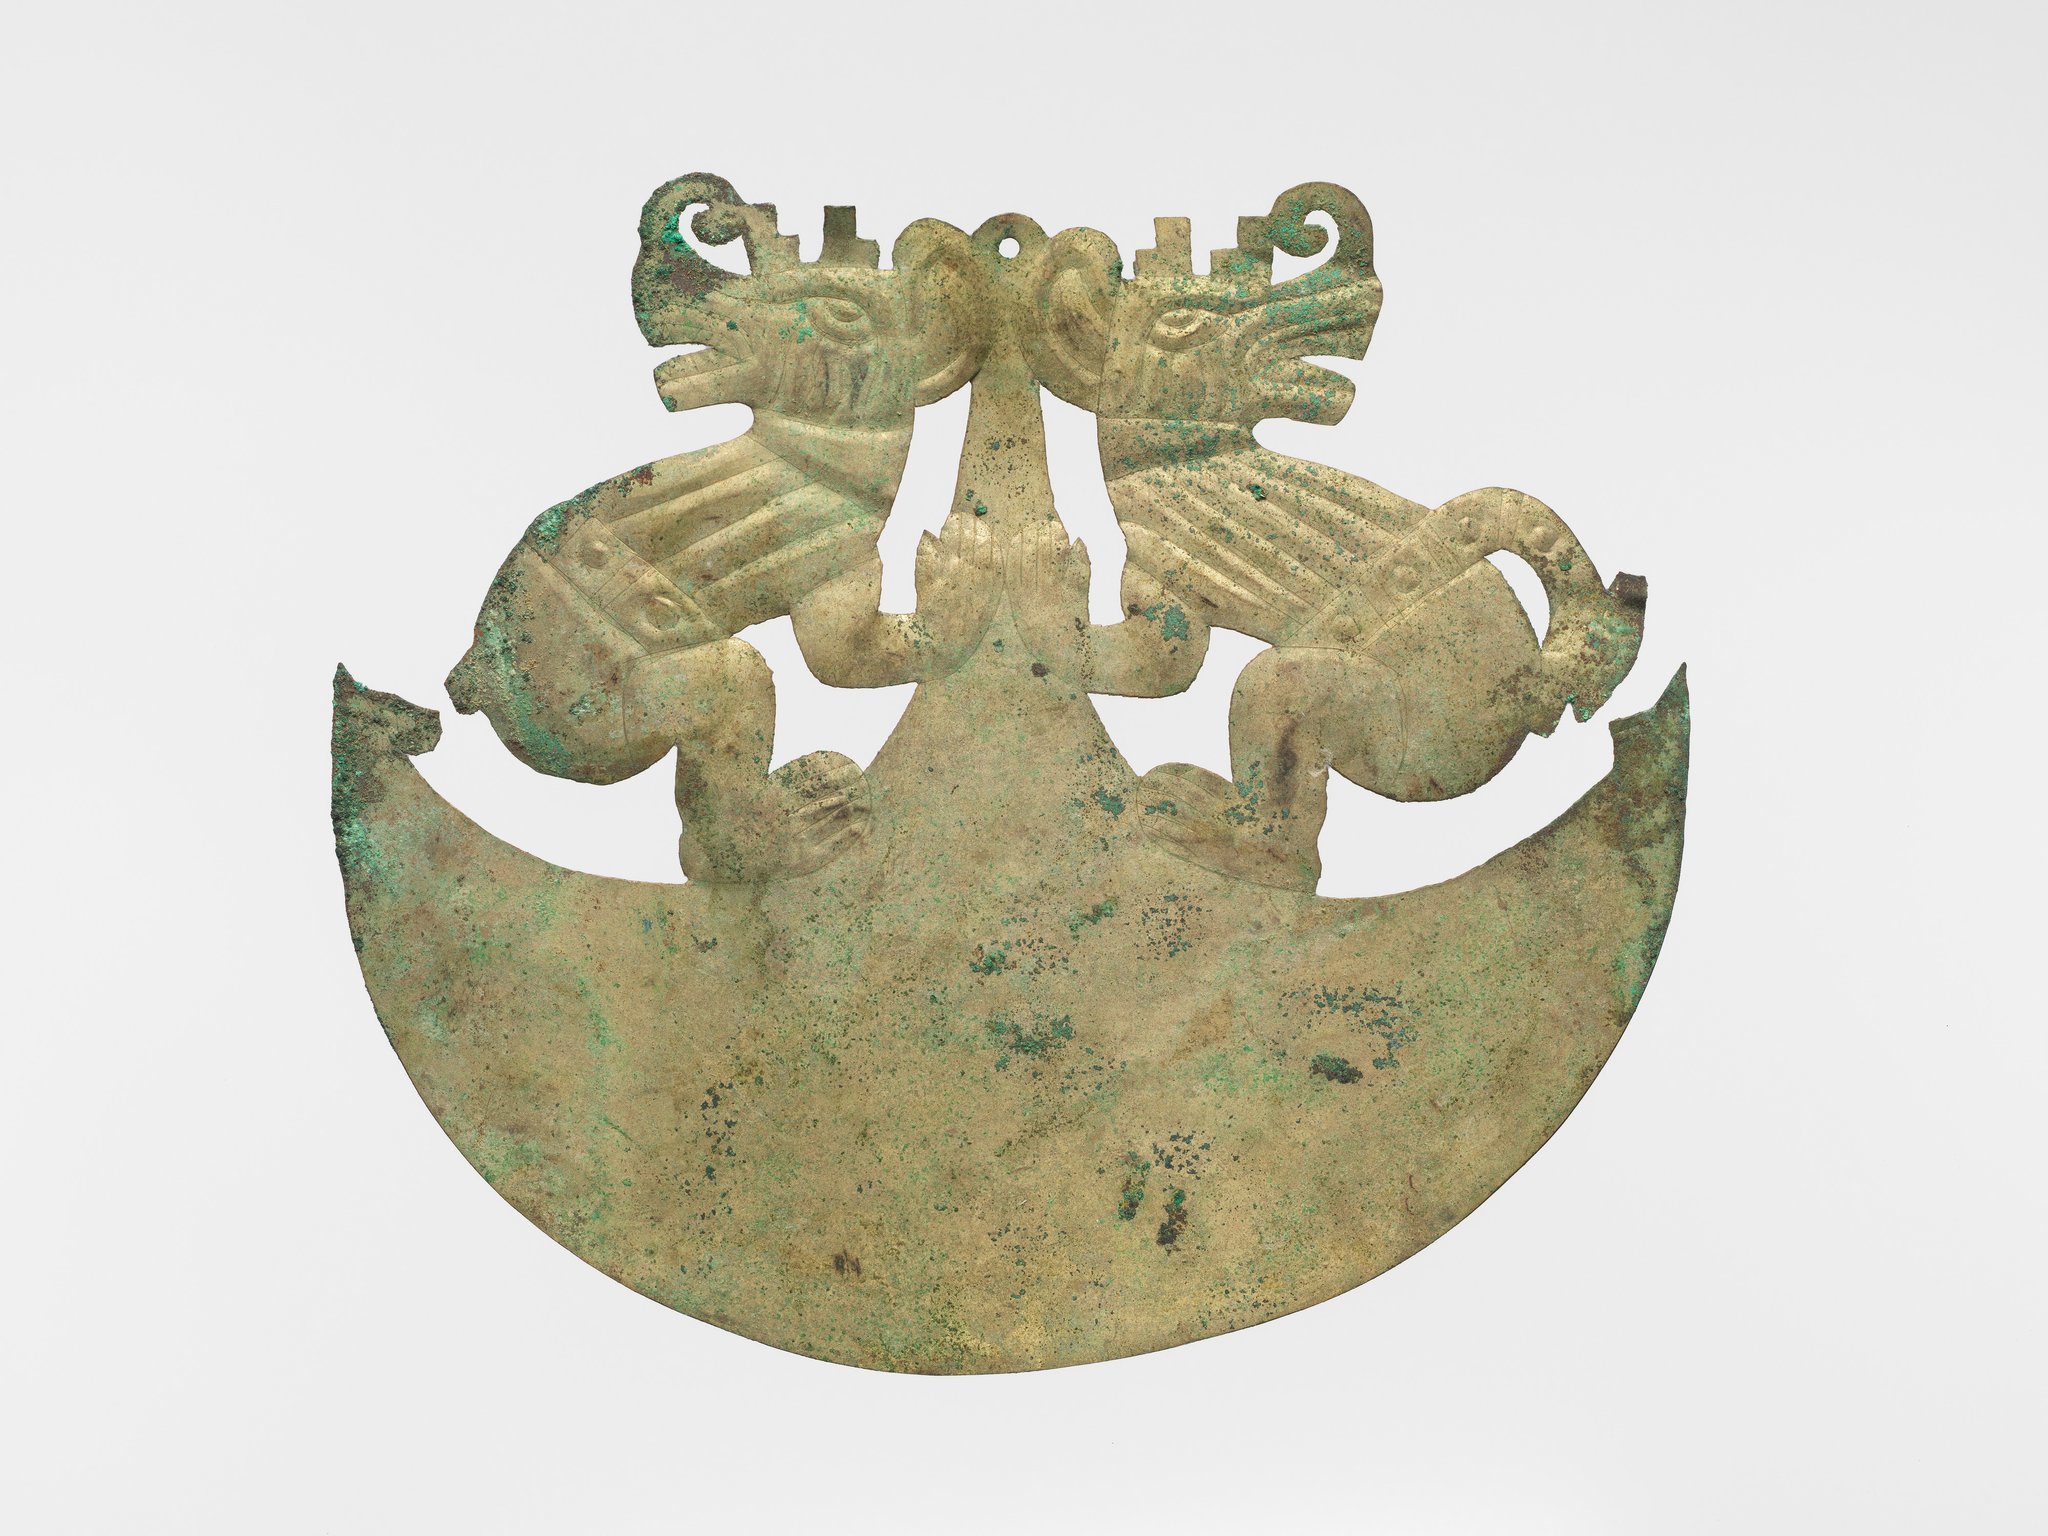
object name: ornament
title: Crescent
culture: moche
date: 501-700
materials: gilt copper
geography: peru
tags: animals